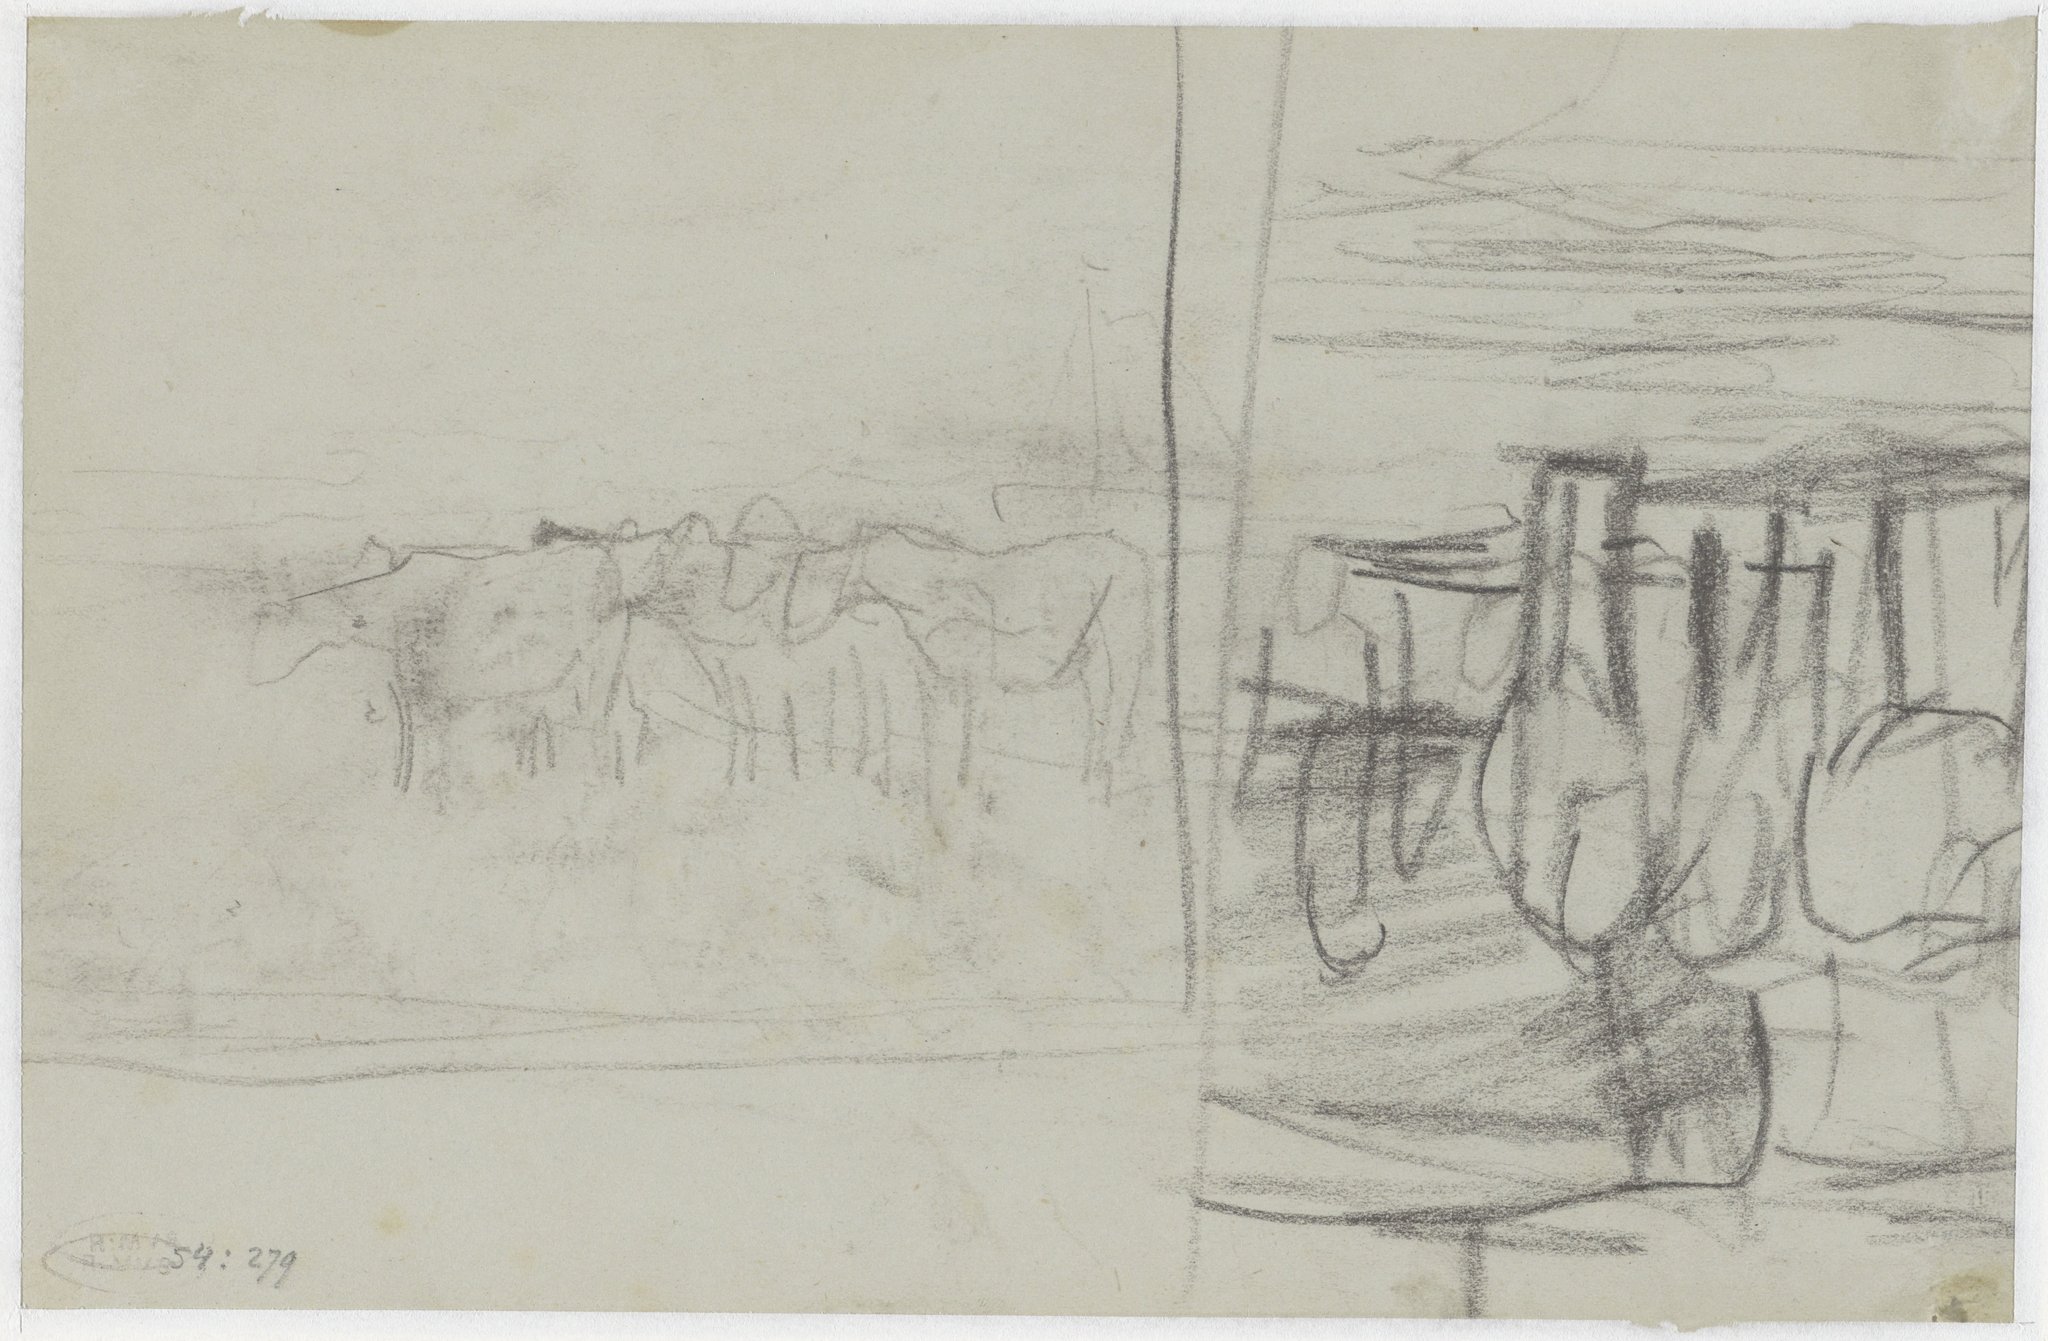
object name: drawing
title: Schetsen van paarden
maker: anton mauve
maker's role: draughtsman, painter, print maker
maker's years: 1838-1888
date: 1848-1888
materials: chalk, paper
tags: horse